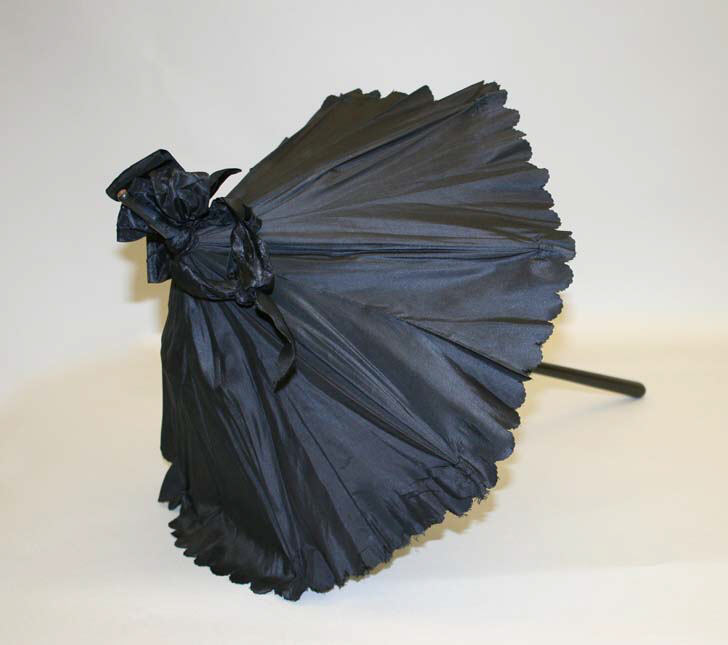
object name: parasol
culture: american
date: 1860